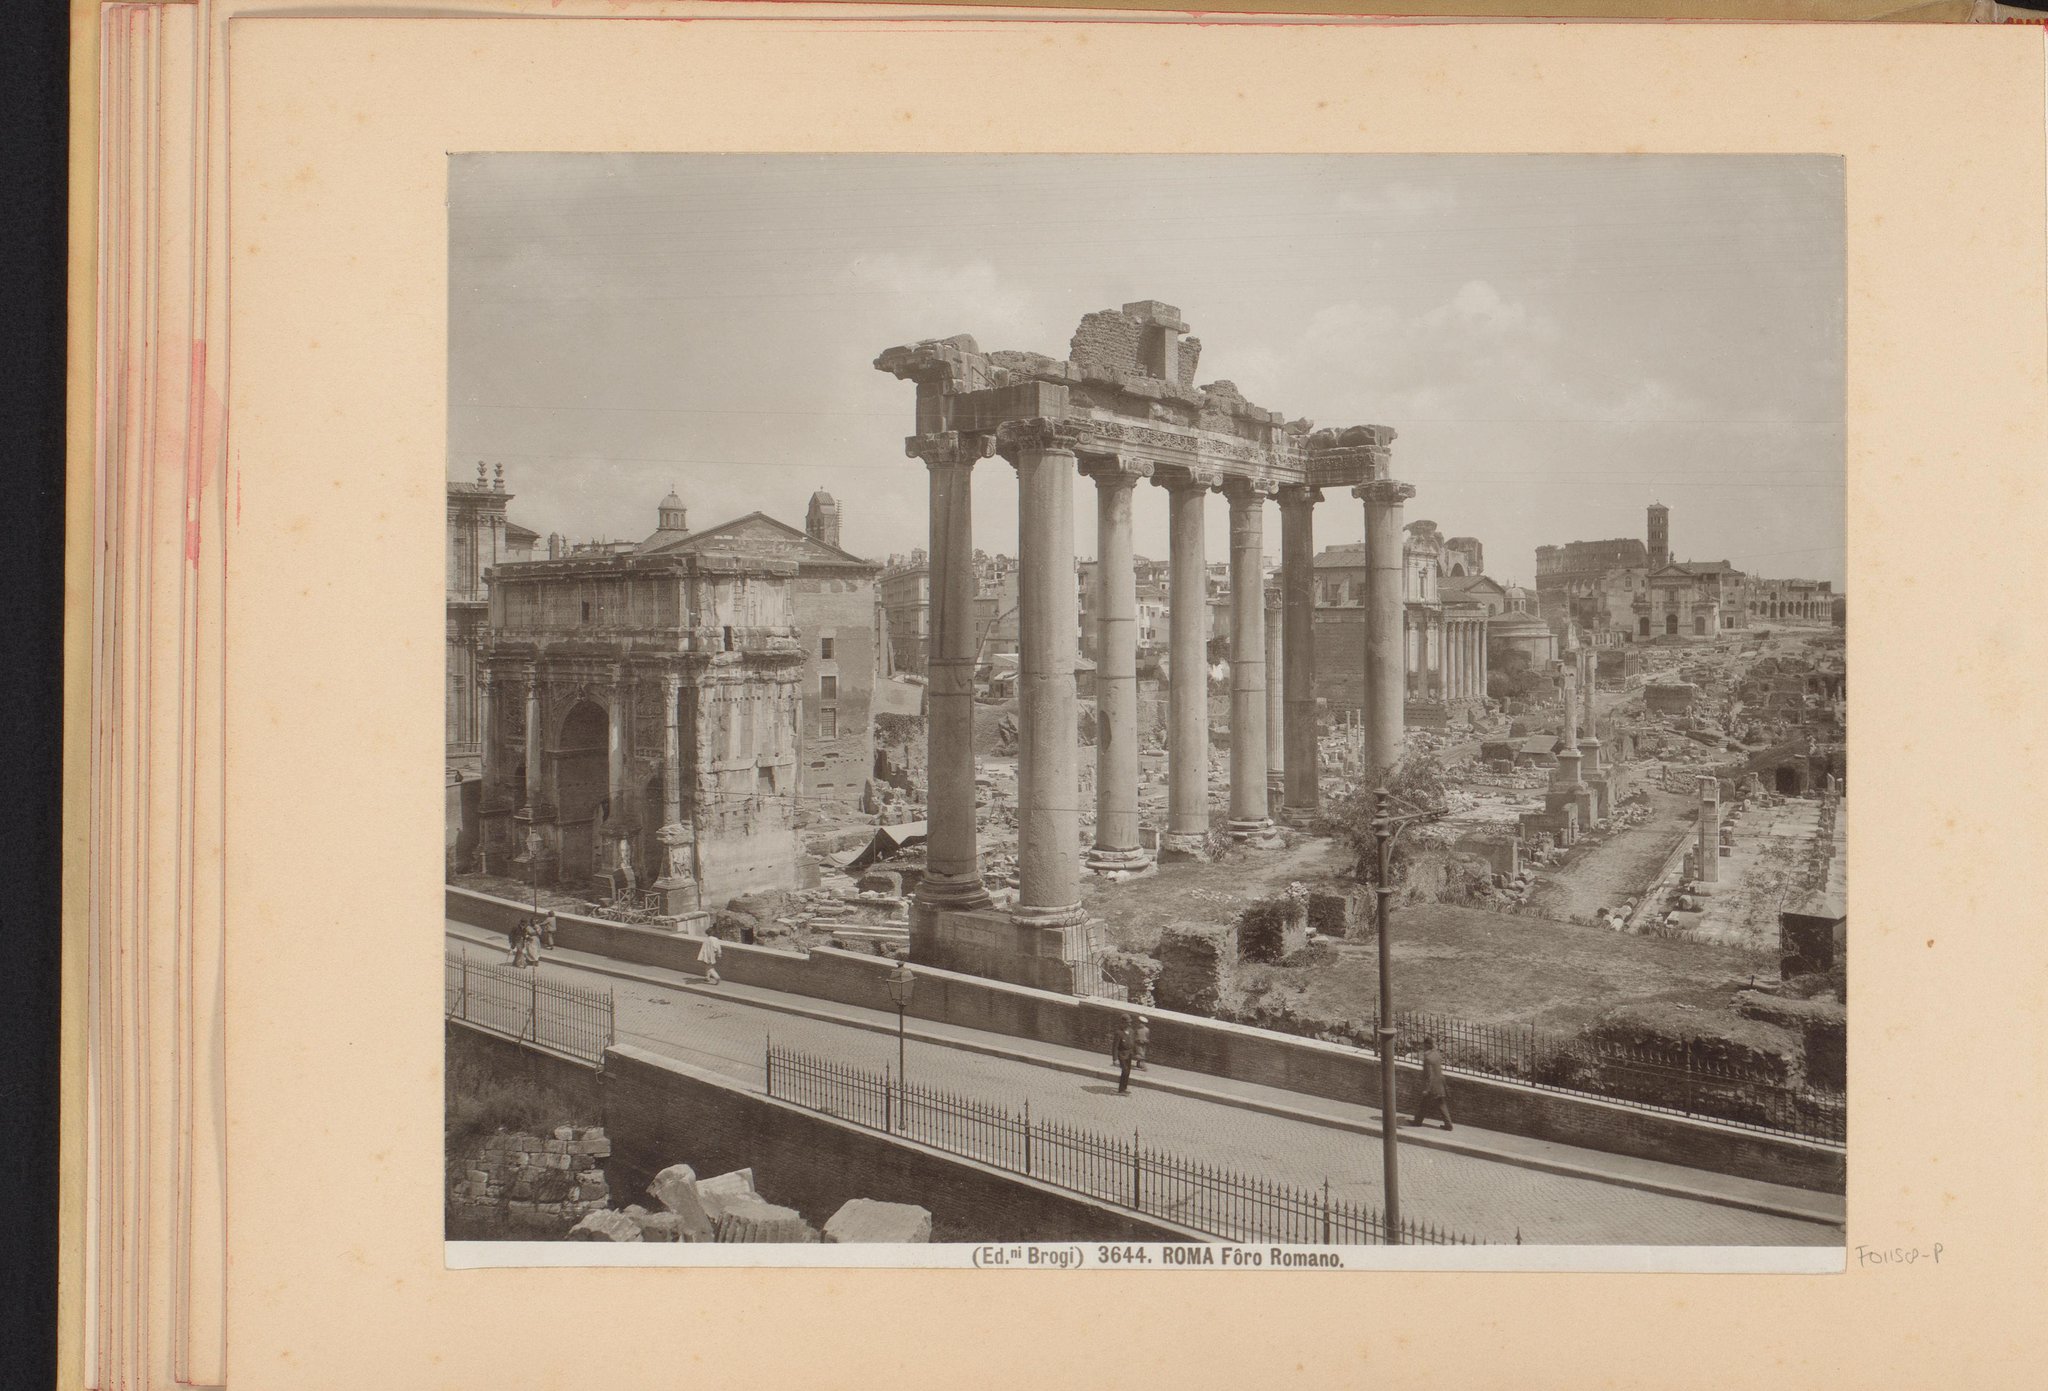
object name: photograph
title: Roma Fôro Romano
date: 1875-1907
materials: photographic support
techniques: gelatin silver print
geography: rome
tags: landscape with ruins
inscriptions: number: ‘3644’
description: Onderdeel van Fotoalbum met opnames van bezienswaardigheden en kunstwerken in Italië.